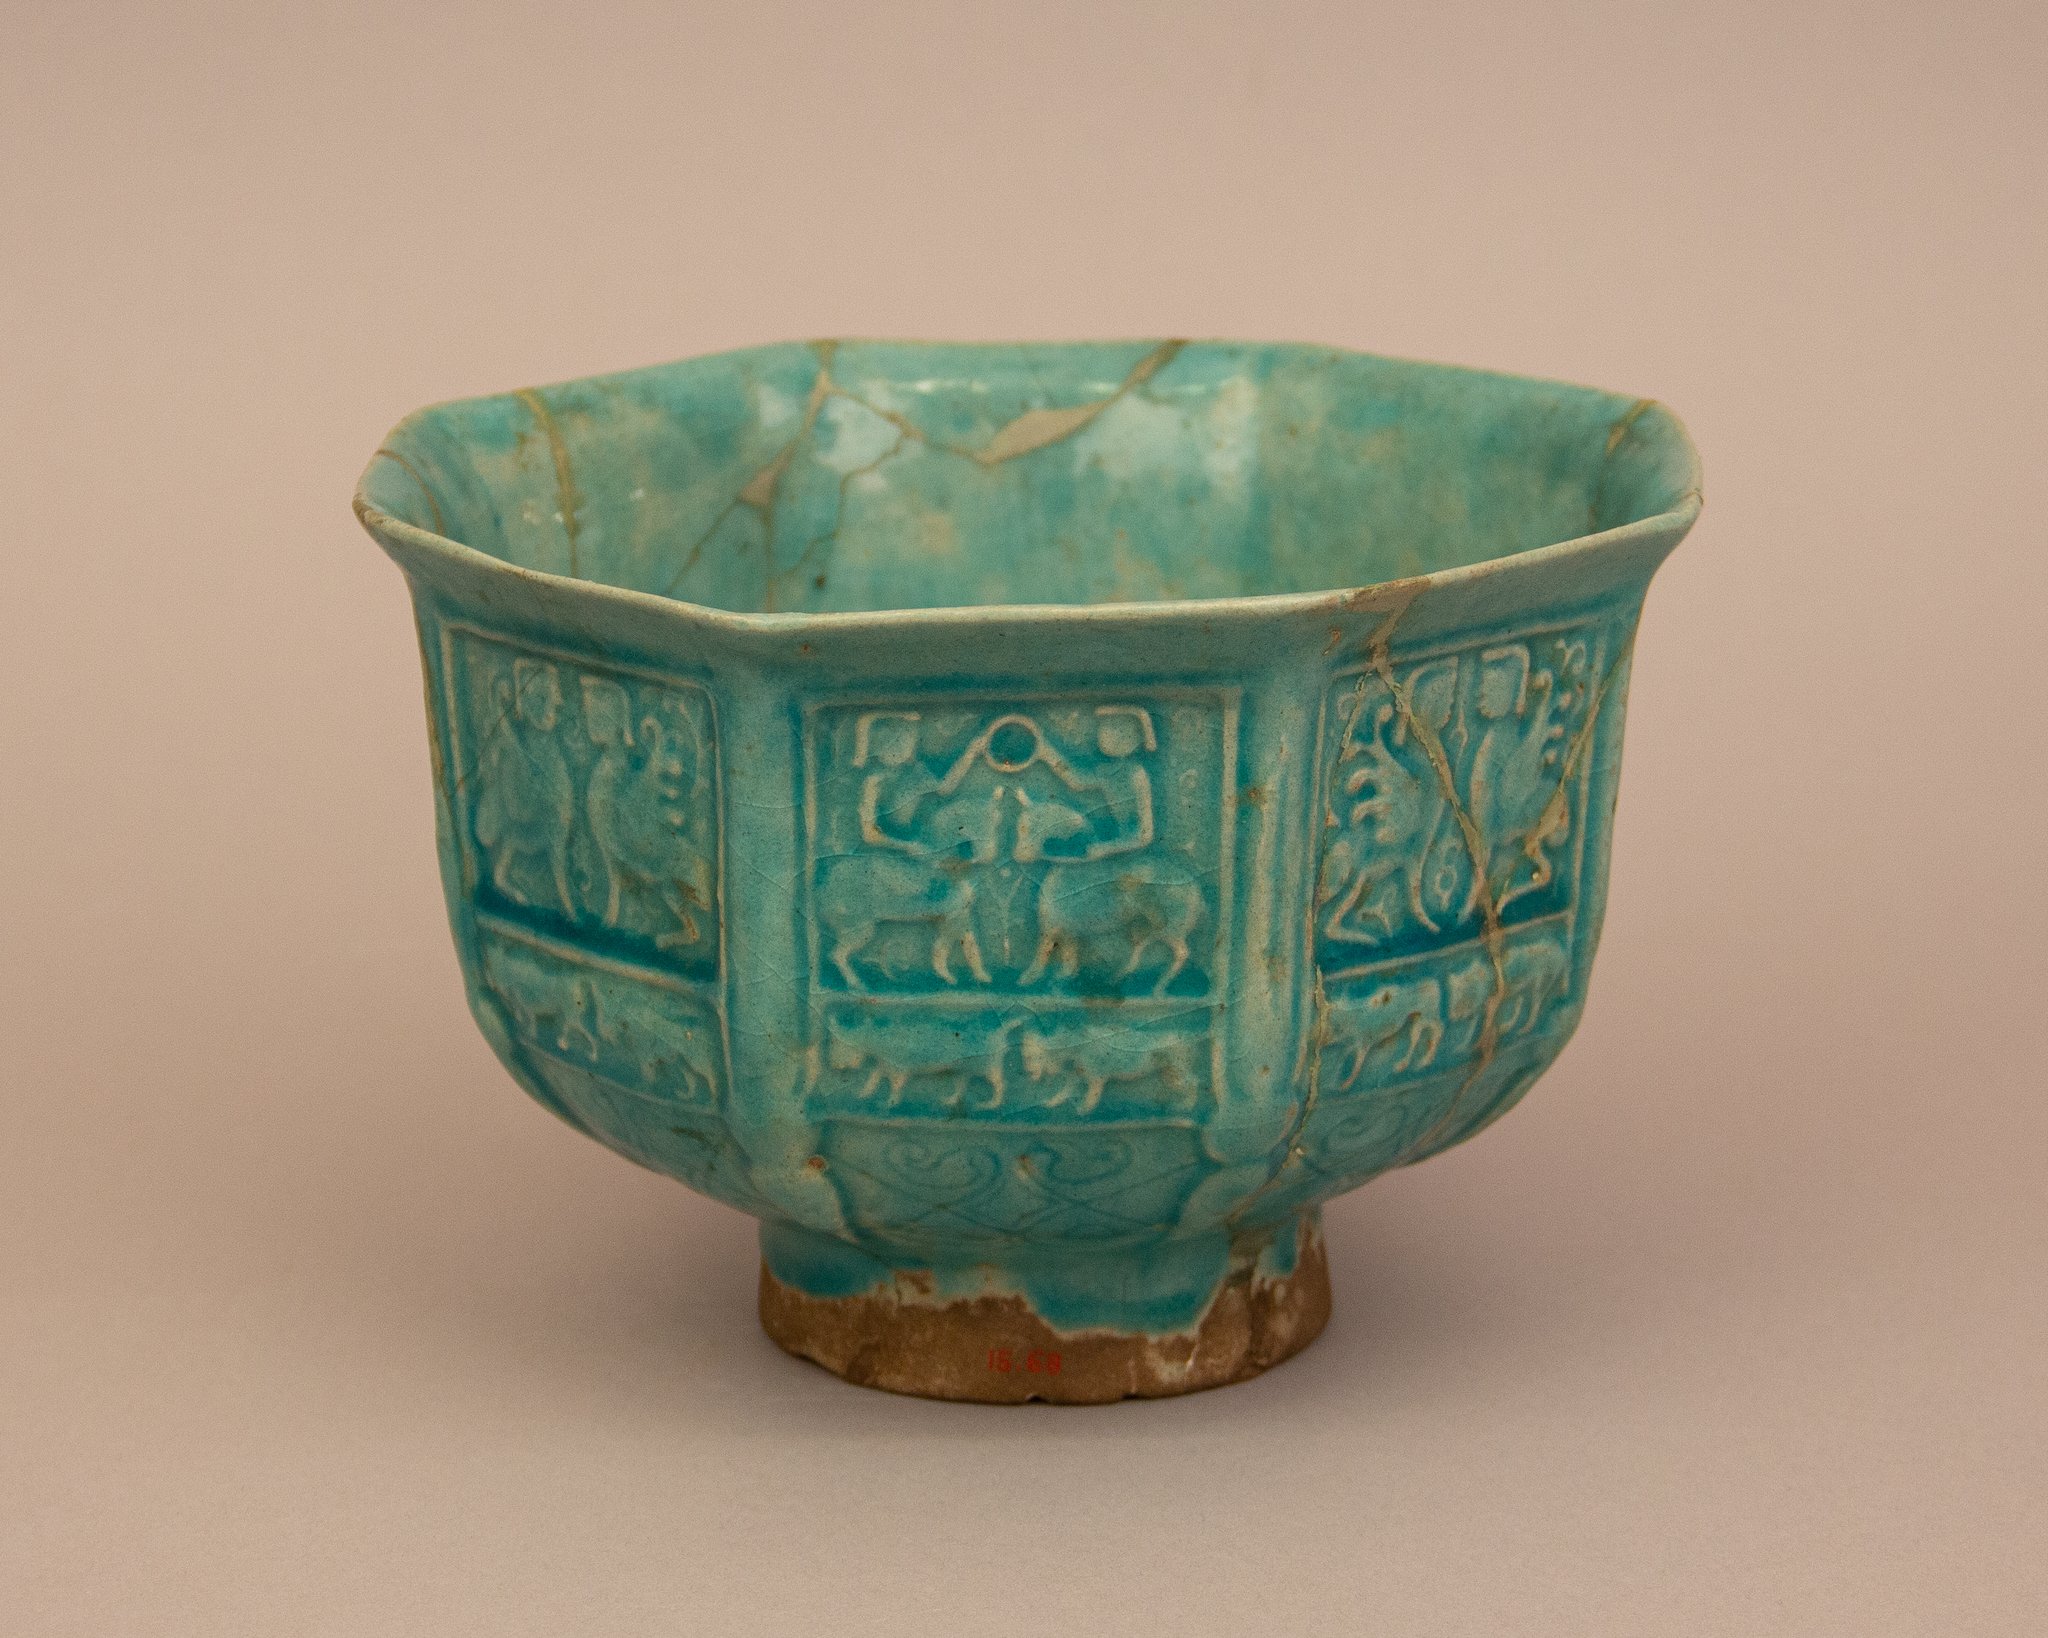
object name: bowl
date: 1101-1300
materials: earthenware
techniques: glazing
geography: iran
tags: sphinx,horses